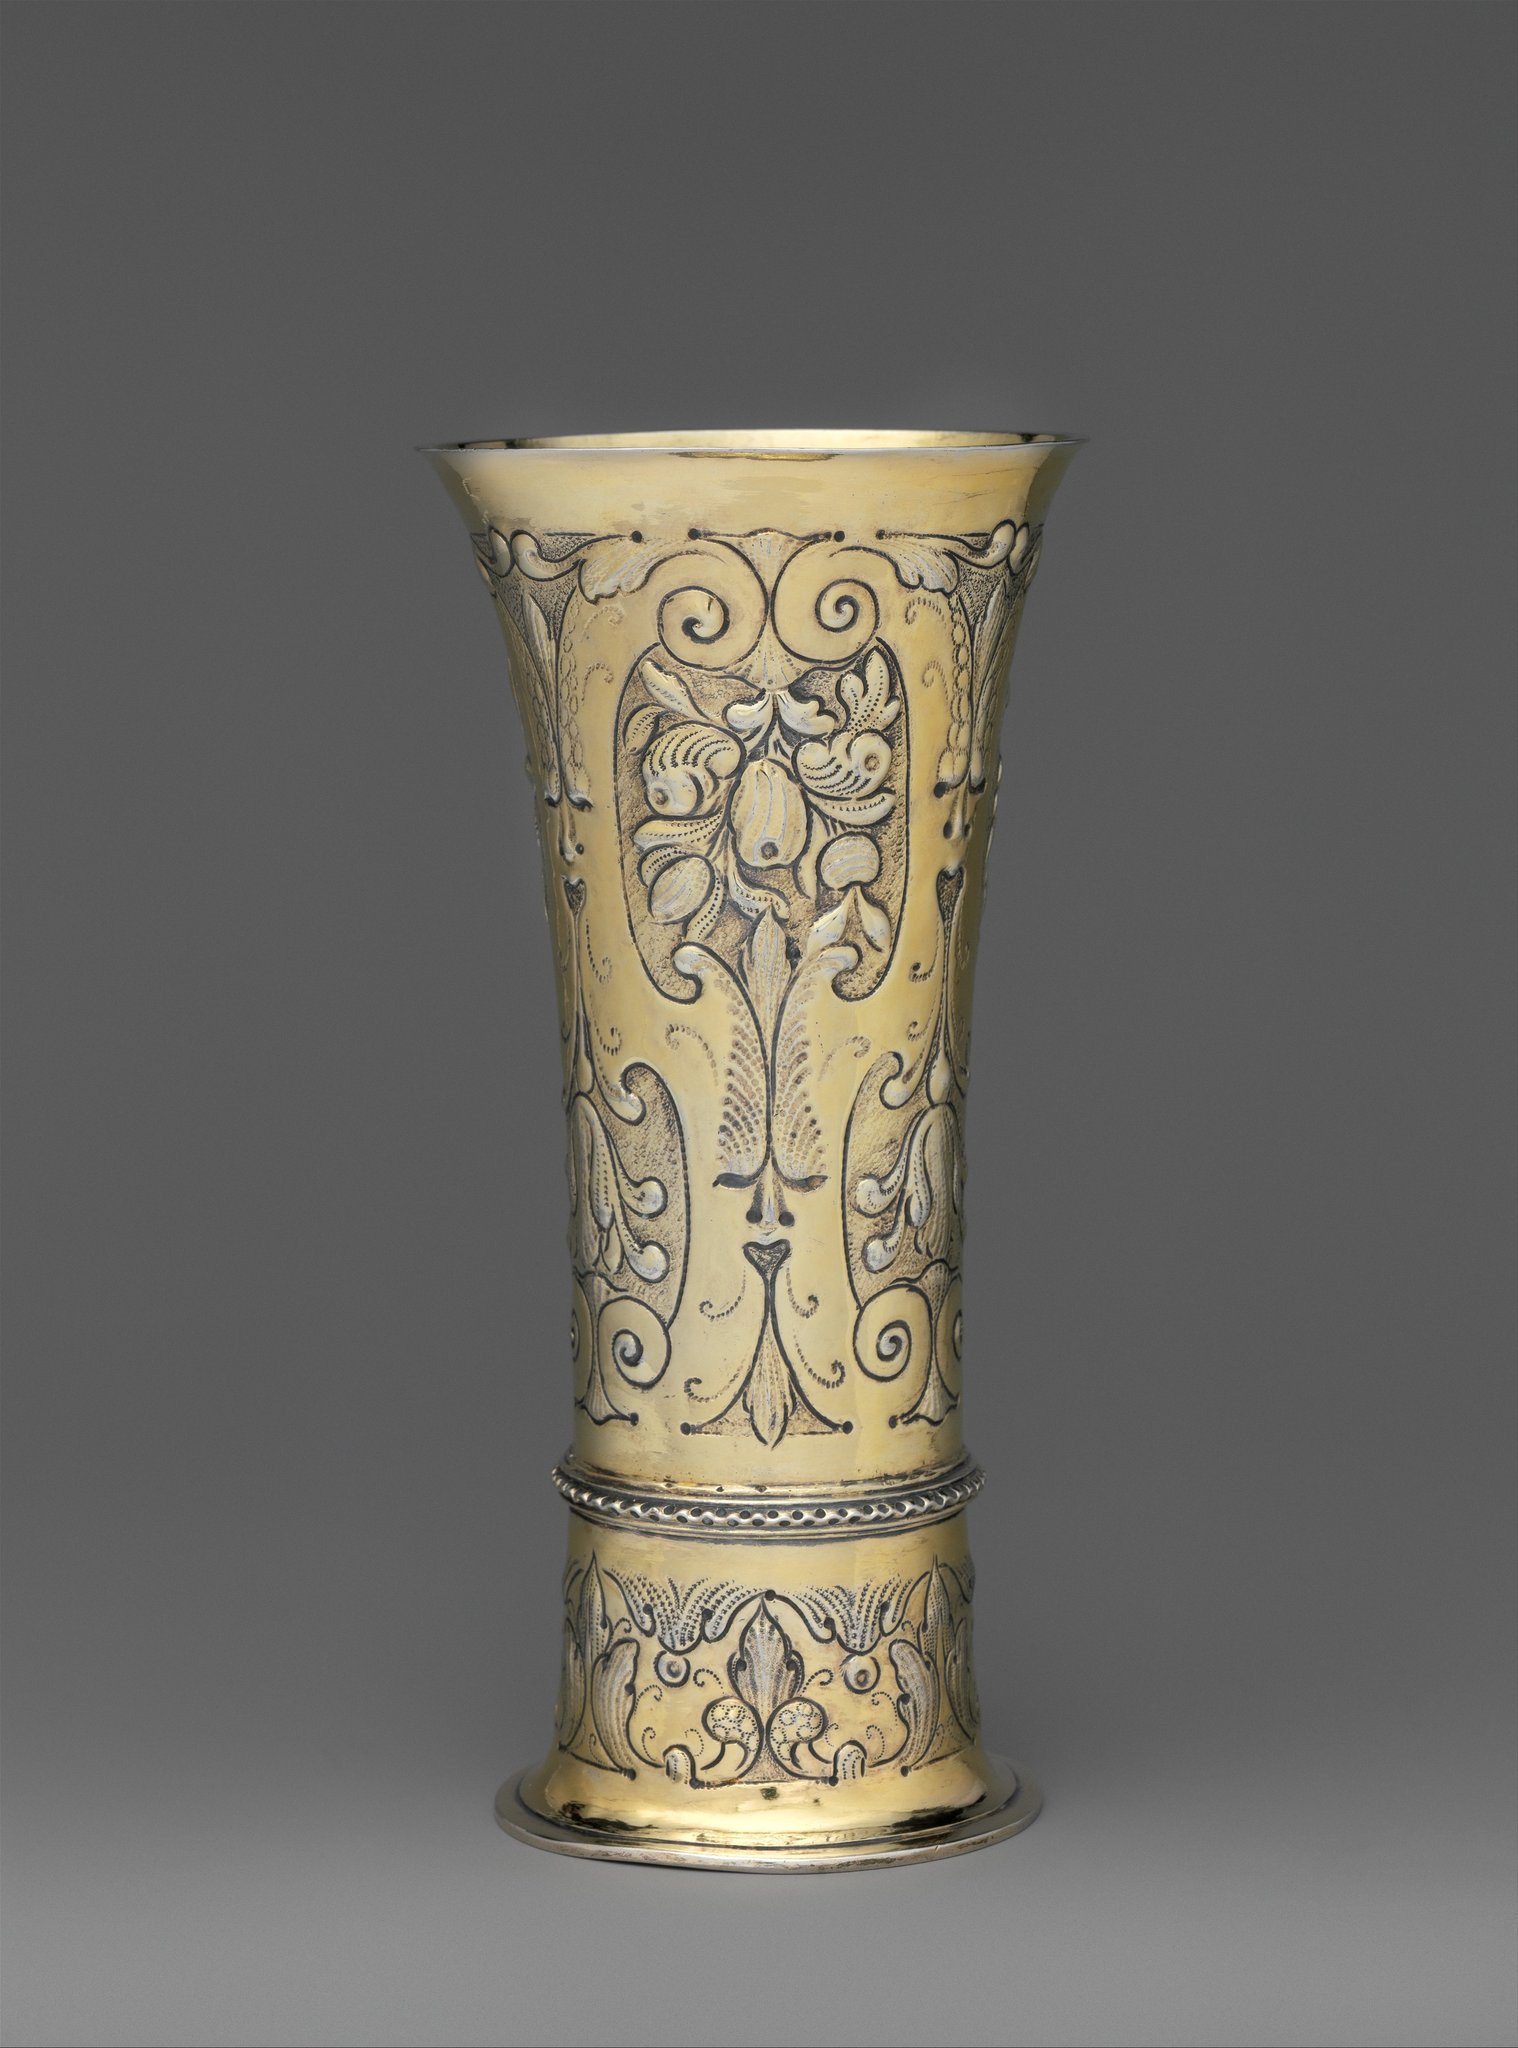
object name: beaker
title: Footed beaker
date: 1680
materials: gilt silver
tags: birds